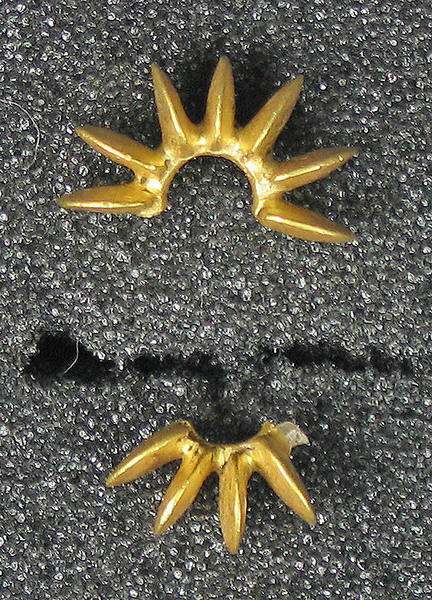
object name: earring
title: Earring with Fused Discs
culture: indonesian, central java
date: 701-1200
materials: gold